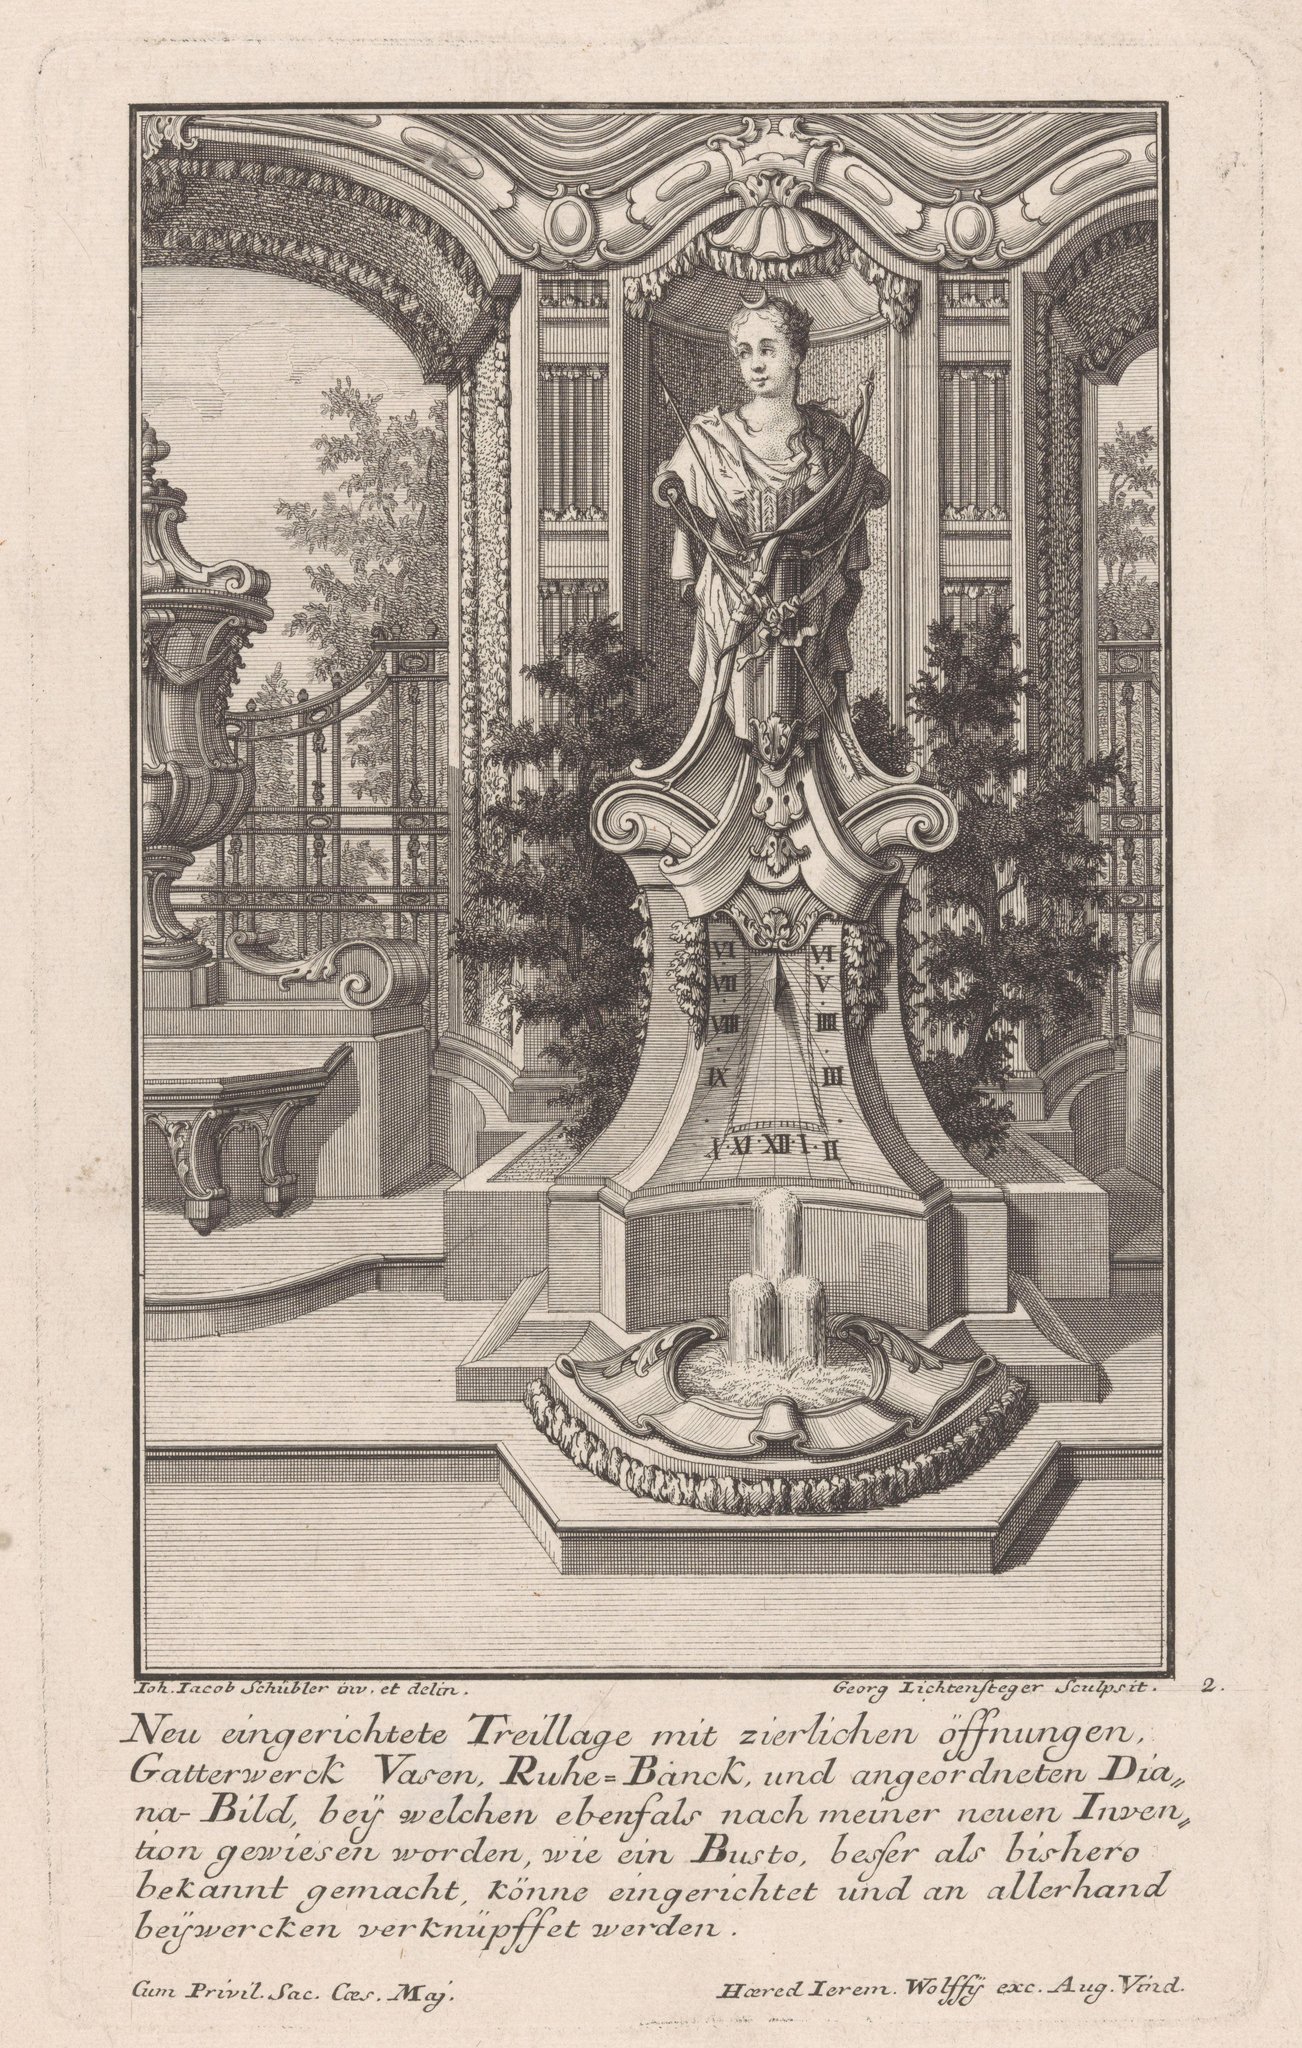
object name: ornament print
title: Johann Jacob Schüblers Neunzehende Ausgabe seines vorhabenden Wercks, Worinnen vorgestellet werden Unterschiedliche Moderne Garten-Ornemens (...)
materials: paper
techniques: engraving, etching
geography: augsburg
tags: (story of) diana (artemis), sundial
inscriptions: collector's mark: Lugt 2228, collector's mark: Lugt 2760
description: In een tuin voor een afscheiding staat een zonnewijzer met fontein en een buste van Diana met pijl en boog. Links voor een hekwerk staat een grote vaas boven een bank. In de ondermarge een zesregelige Duitse tekst.